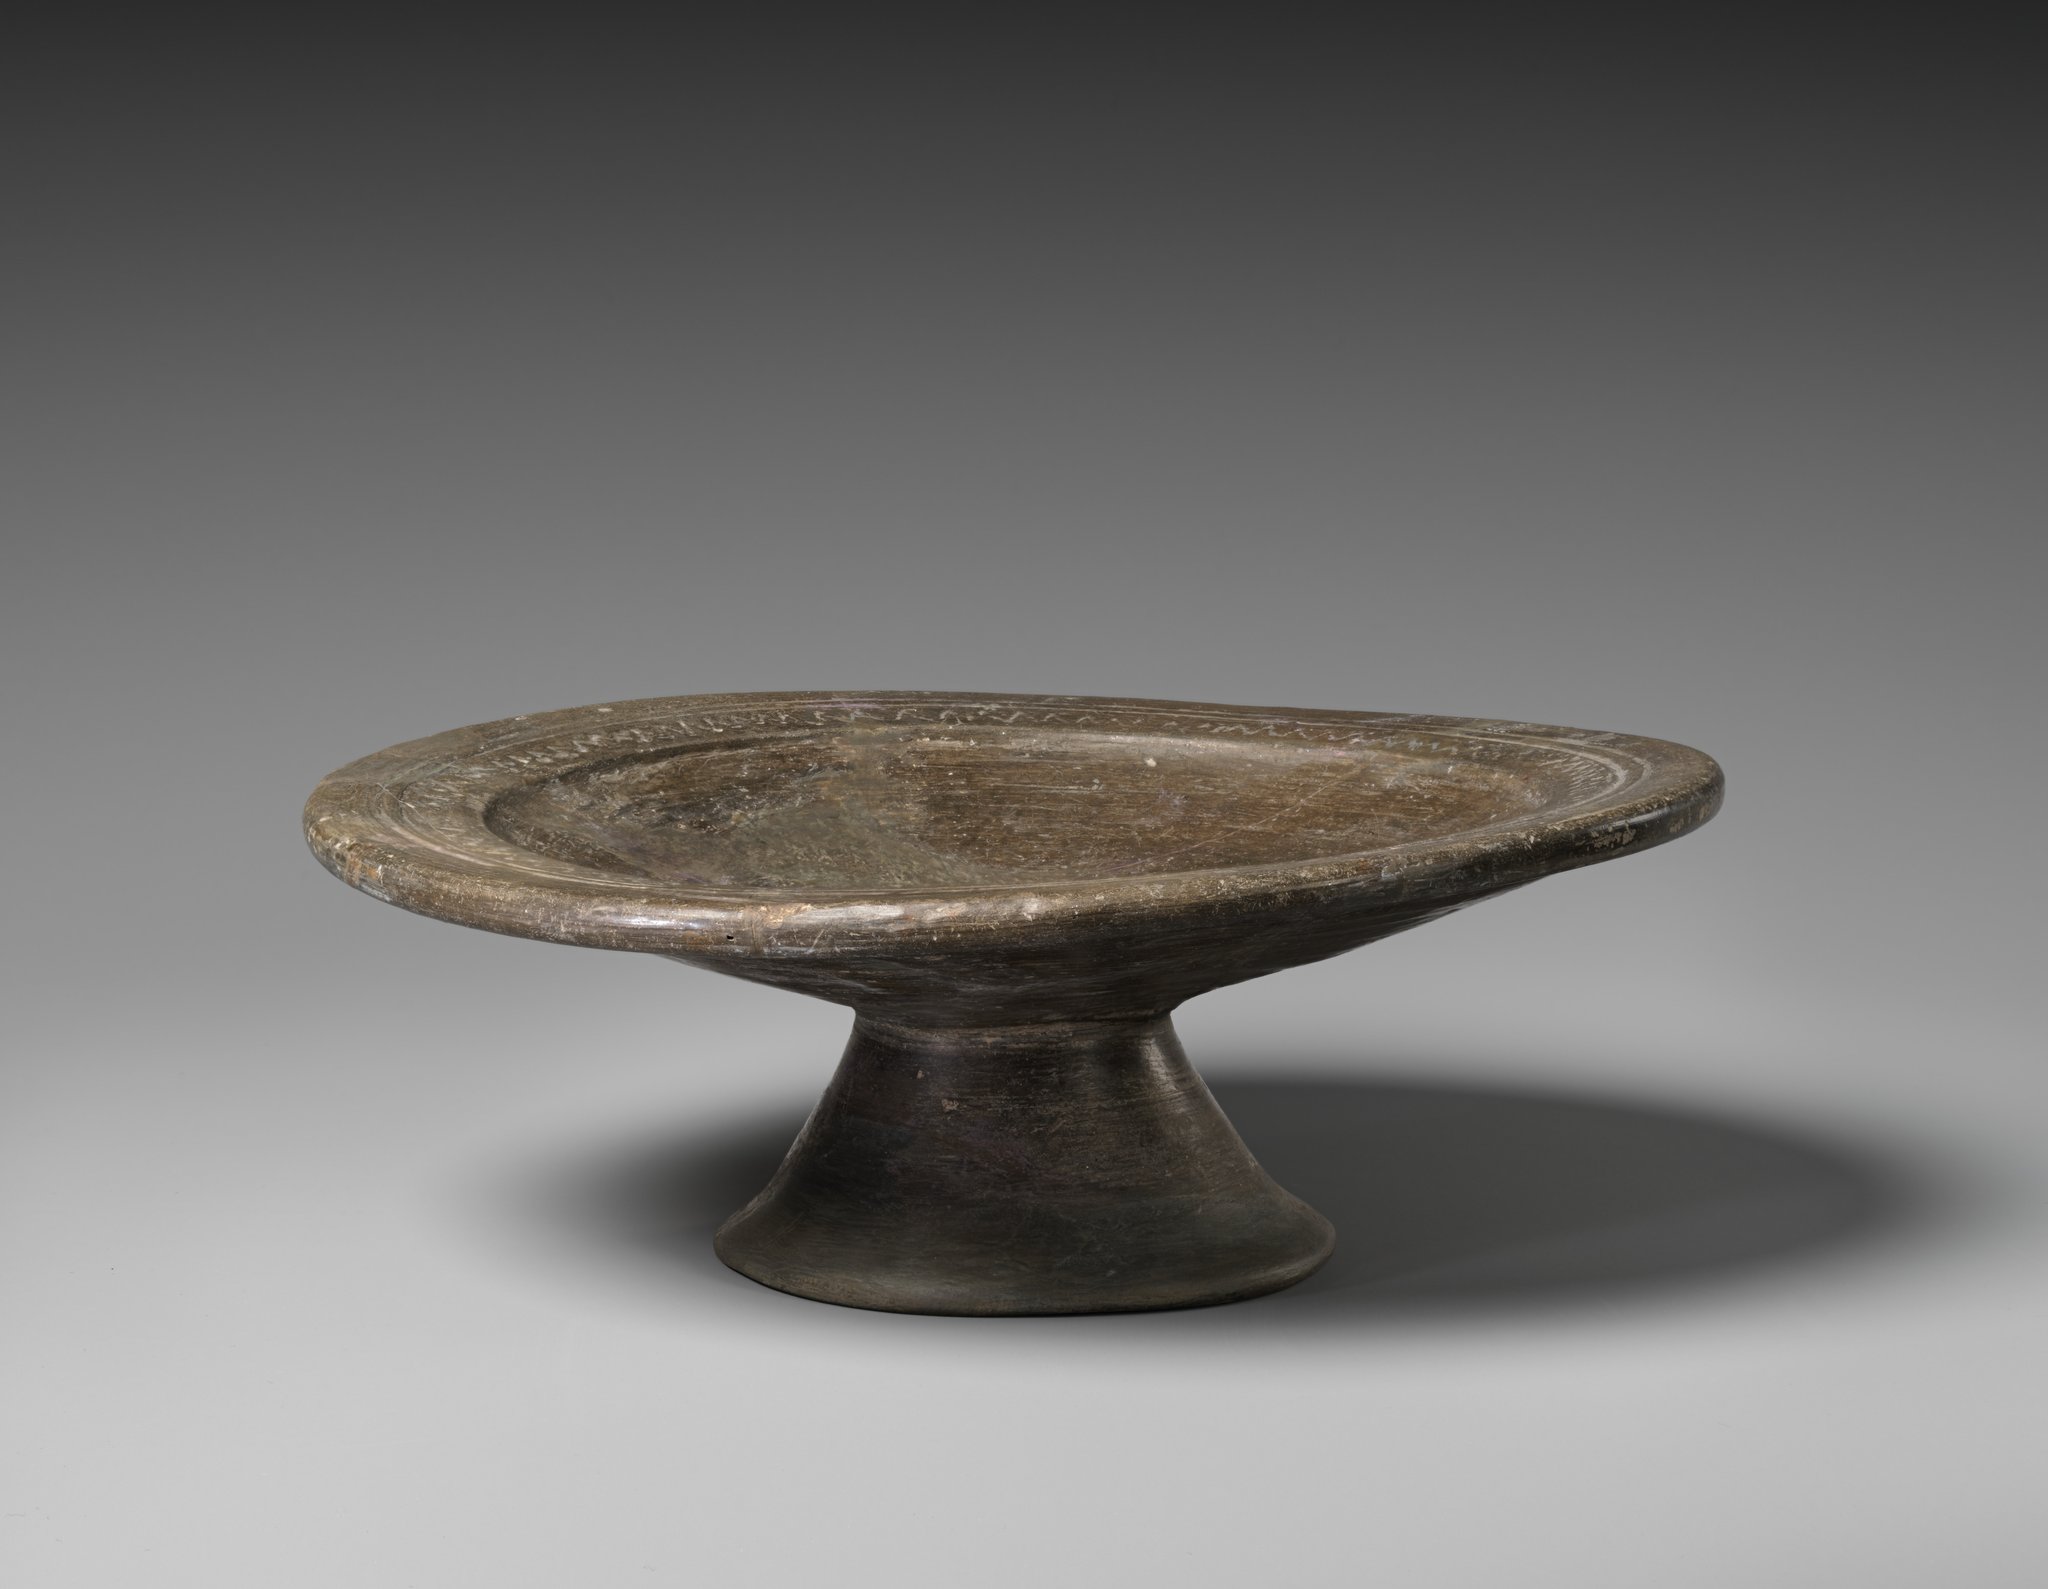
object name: footed dish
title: Terracotta footed dish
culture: lydian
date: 700-501 BCE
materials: terracotta